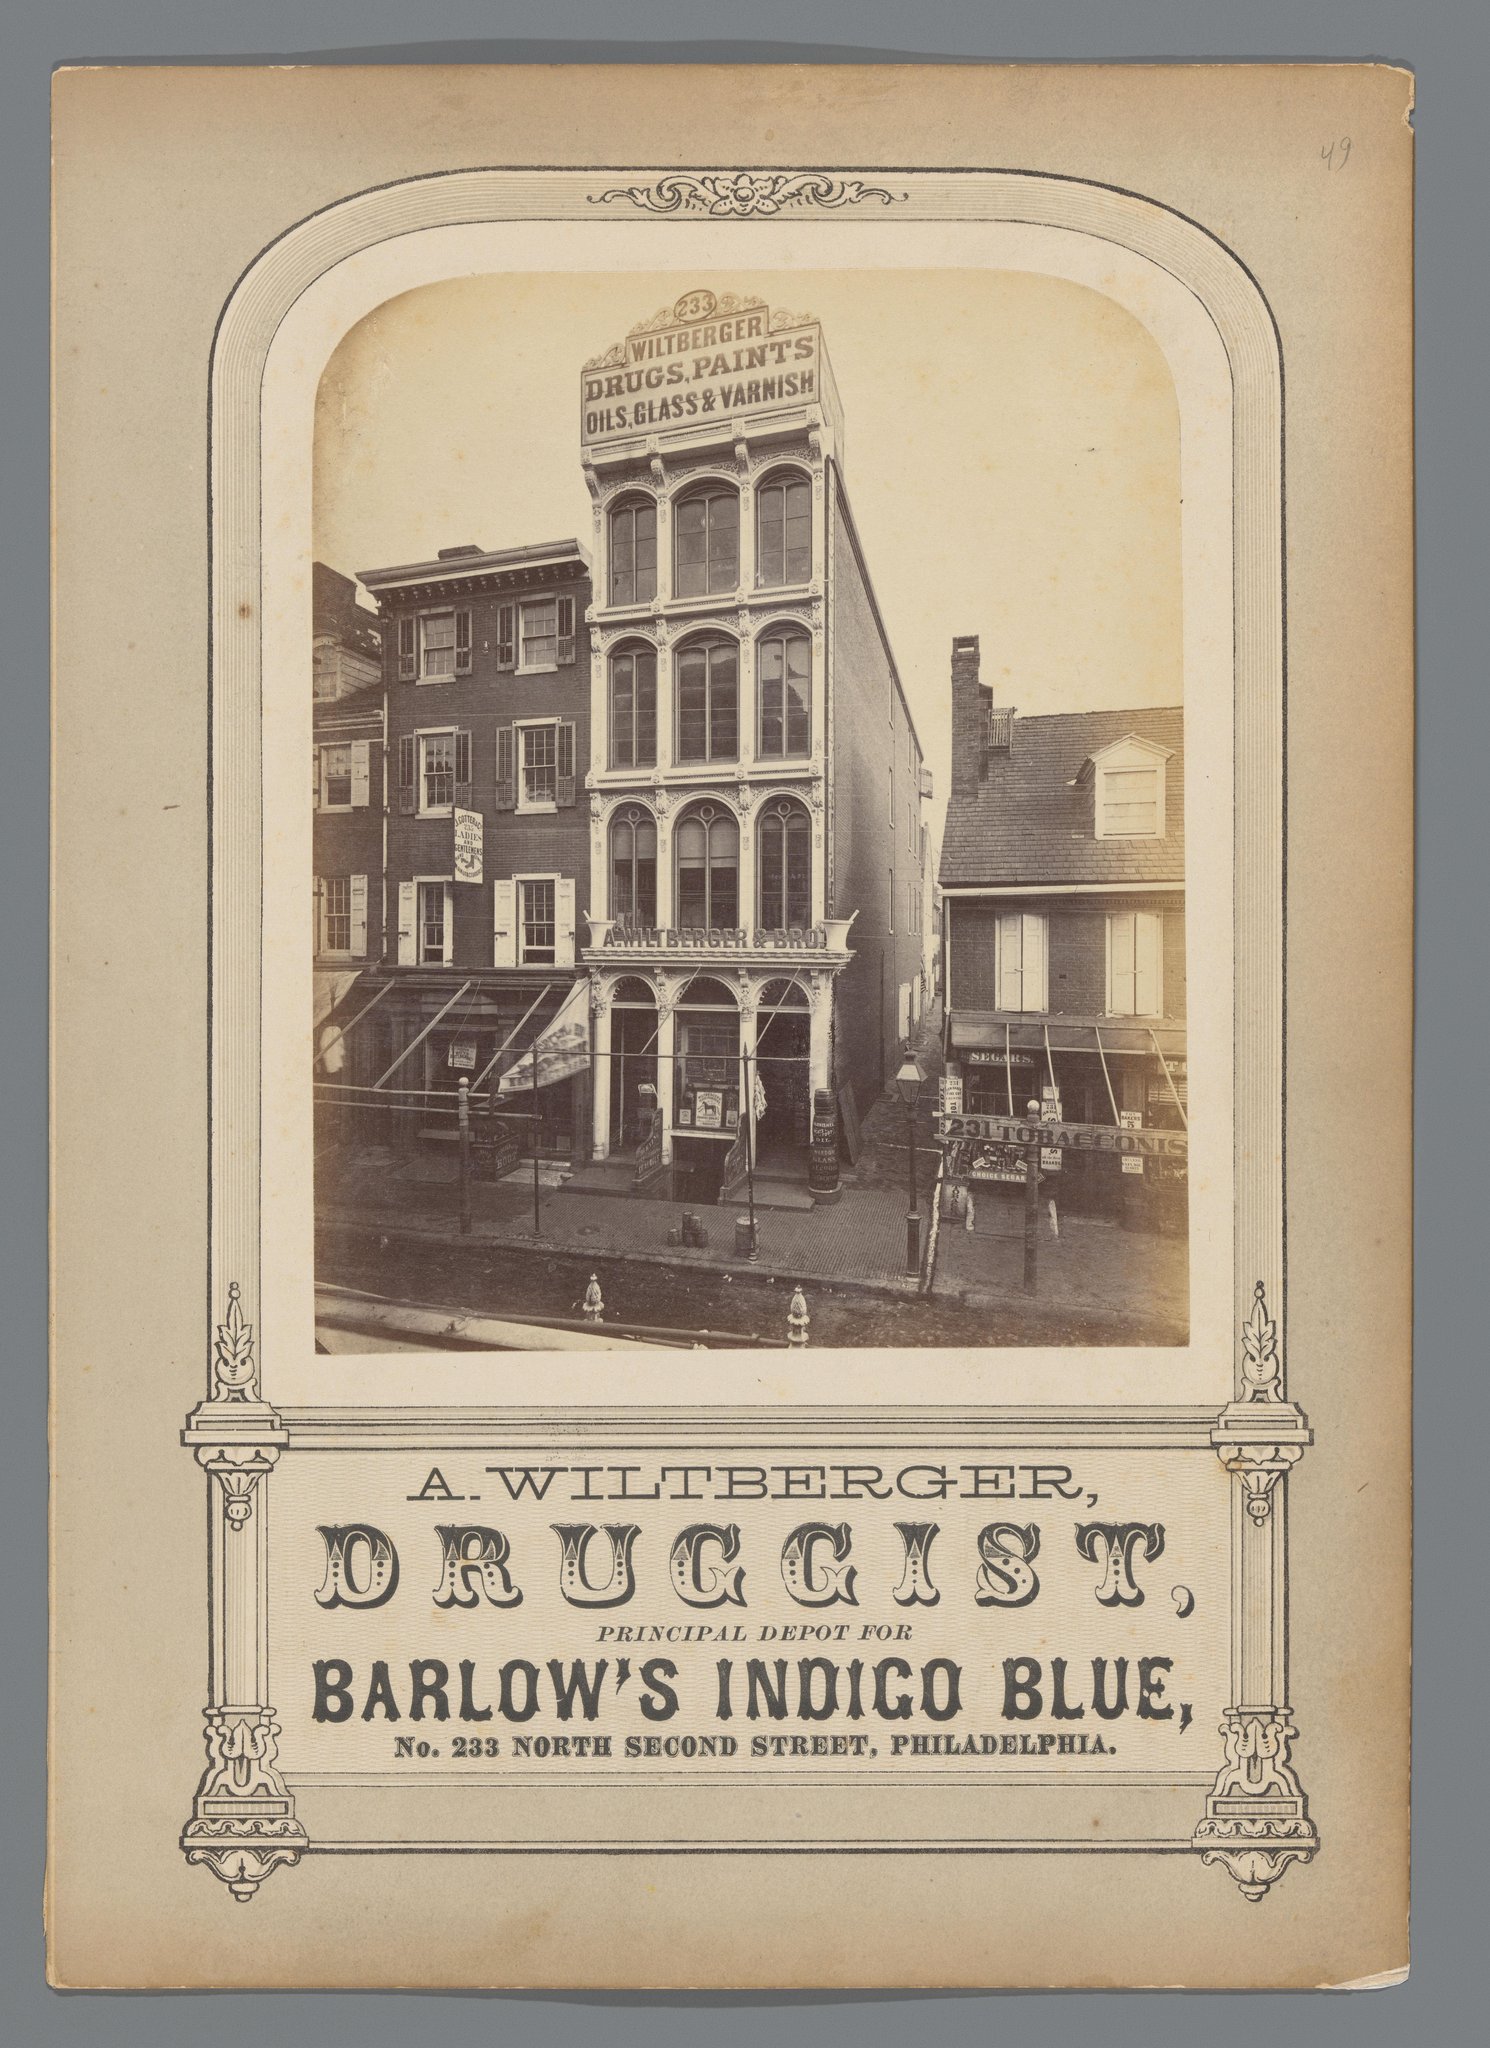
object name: photograph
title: Façade van A. Wiltberger, Druggist, 233 North Second Street, Philadelphia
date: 1871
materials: cardboard, paper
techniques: albumen print, printed materials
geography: philadelphia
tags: philadelphia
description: Pagina uit Gallery of Arts and Manufactures of Philadelphia.